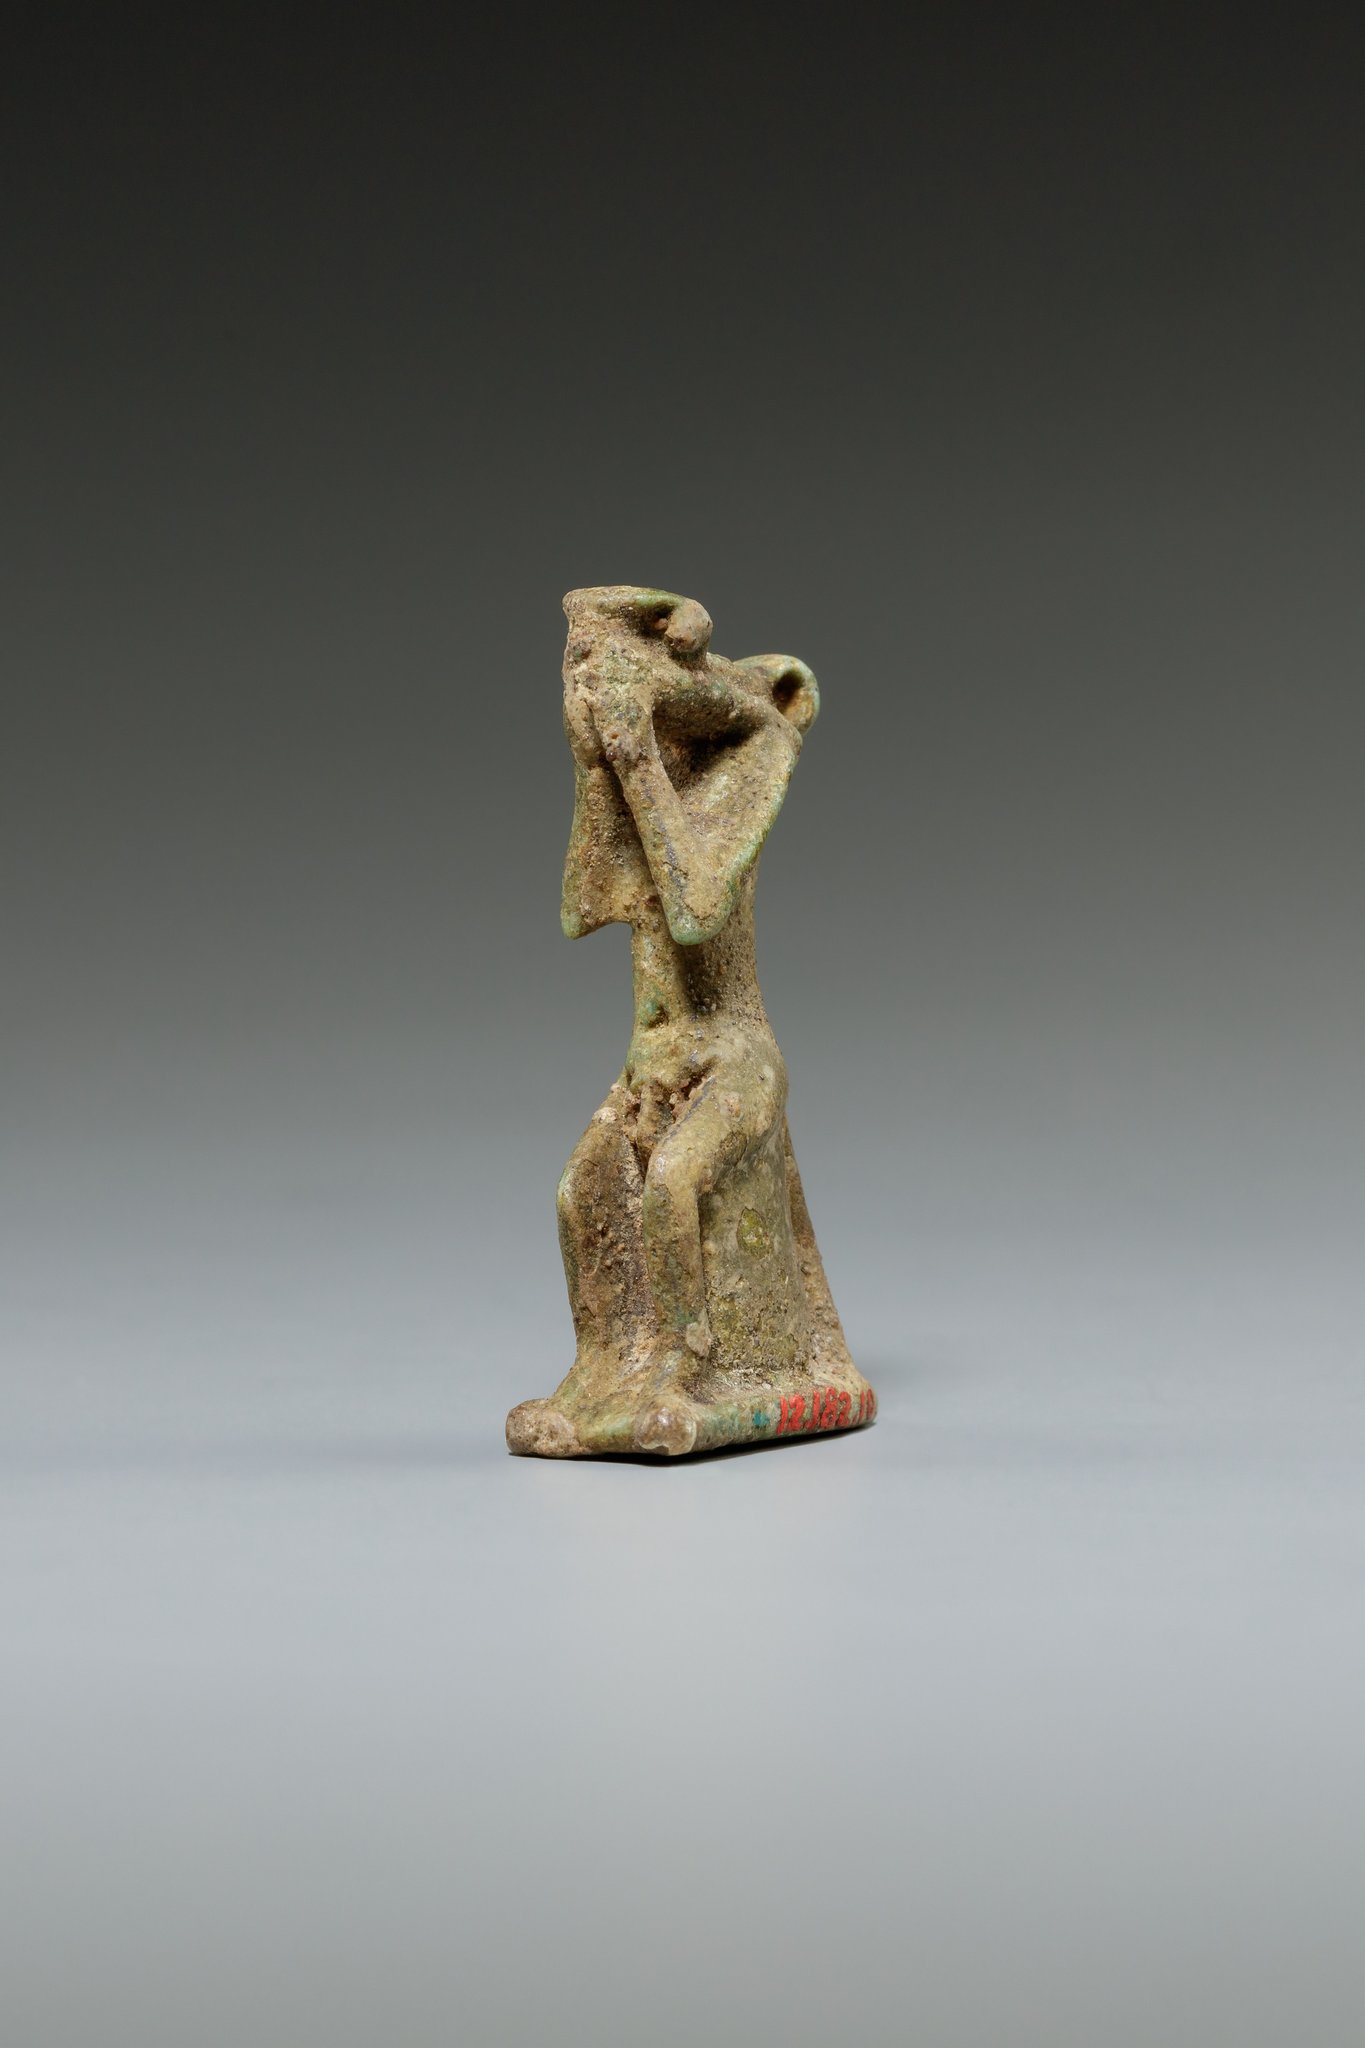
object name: amulet, nehebkau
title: Nehebkau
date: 664-630 BCE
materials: faience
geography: egypt